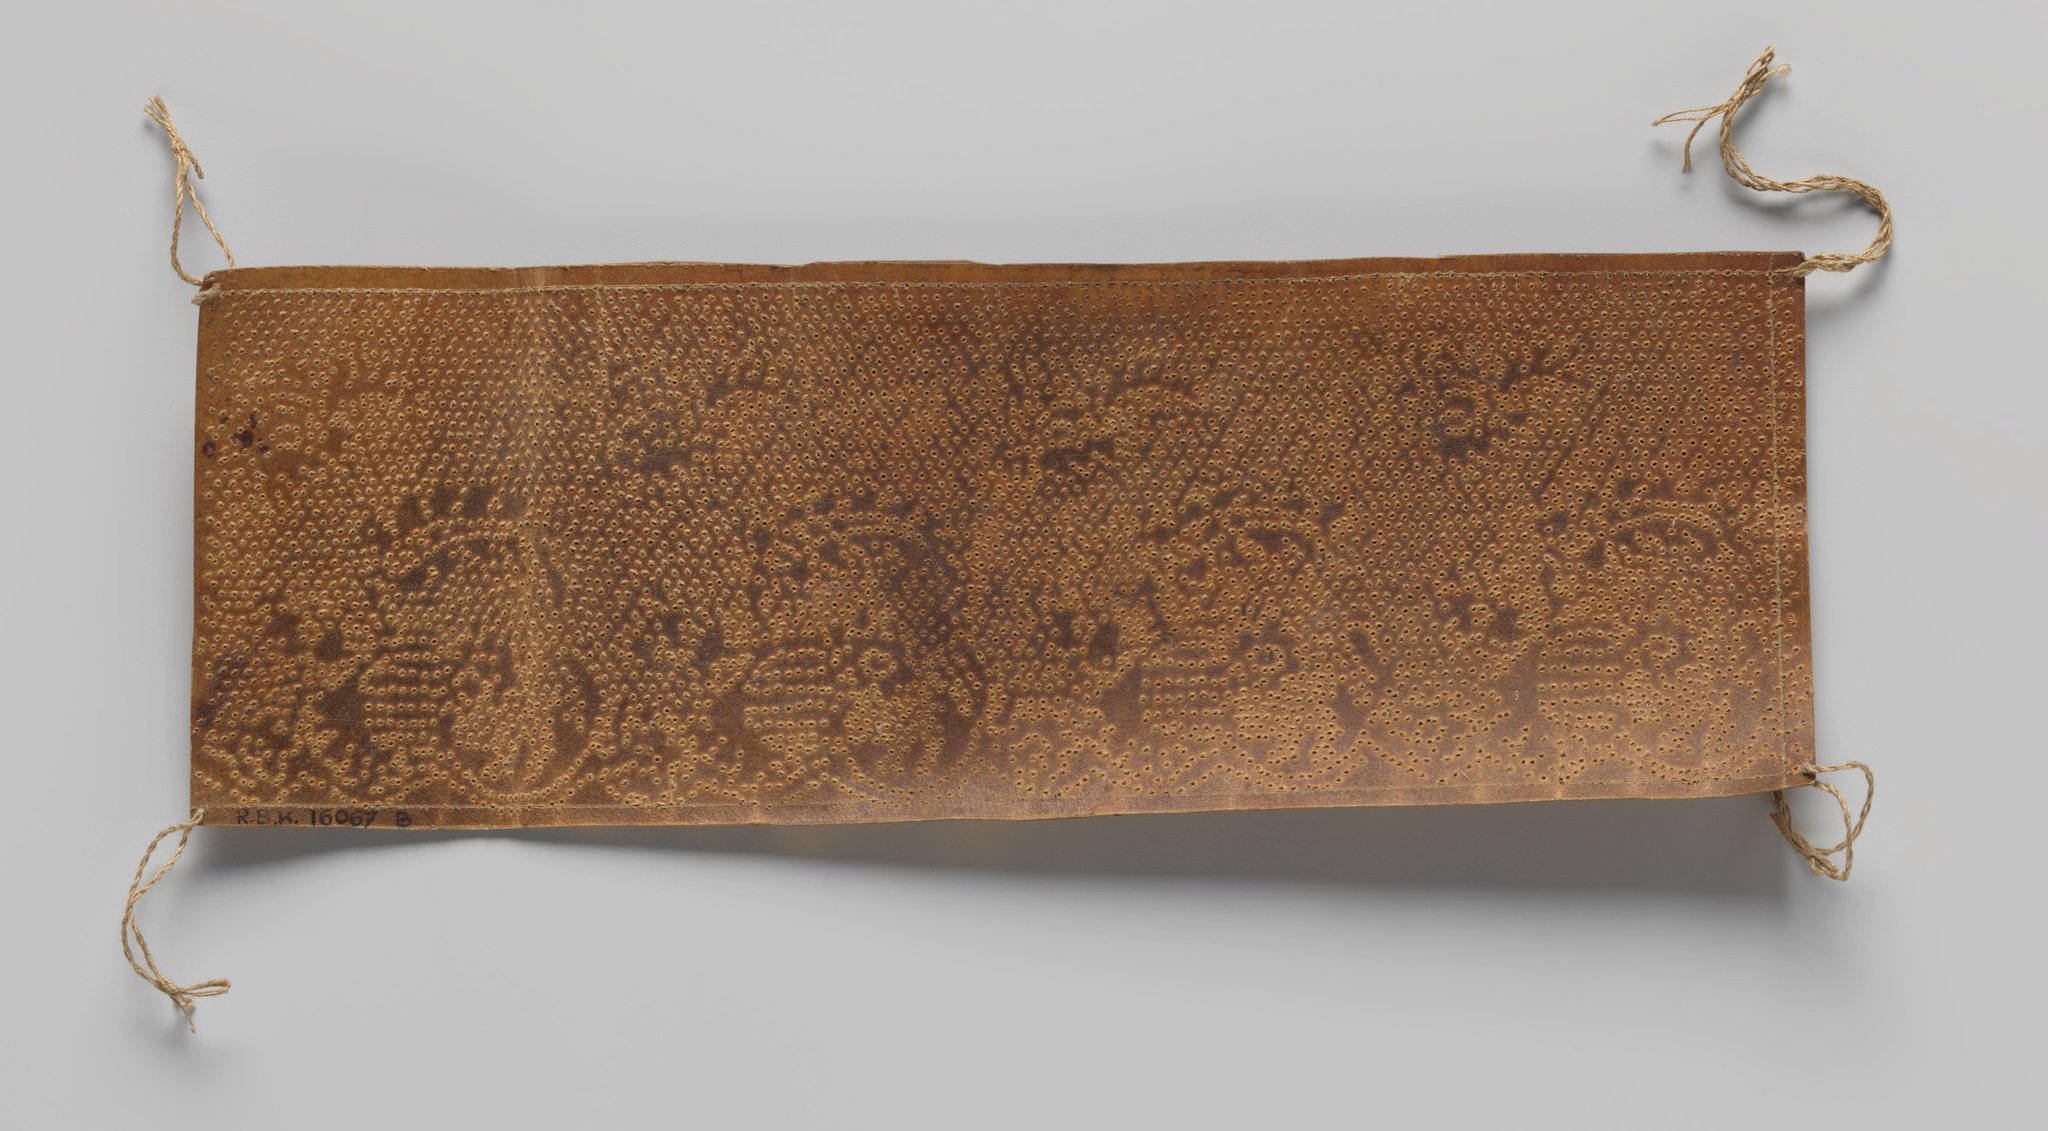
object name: lace pattern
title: Patroon voor een strook kloskant op bruin perkament met gebogen bladeren en bovenaan gestrooide bloemen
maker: Anonymous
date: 1600-1799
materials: parchment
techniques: pricking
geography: southern netherlands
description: Patroon voor een strook kloskant - Valenciennes-kant - geprikt in bruin gekleurd perkament. Het zich herhalende en doorlopende patroon bestaat uit een bloem, schulpen en gebogen bladeren en bovenaan gestrooide bloemen. In elke hoek is in een gaatje een touwtje aan het leer geknoopt.